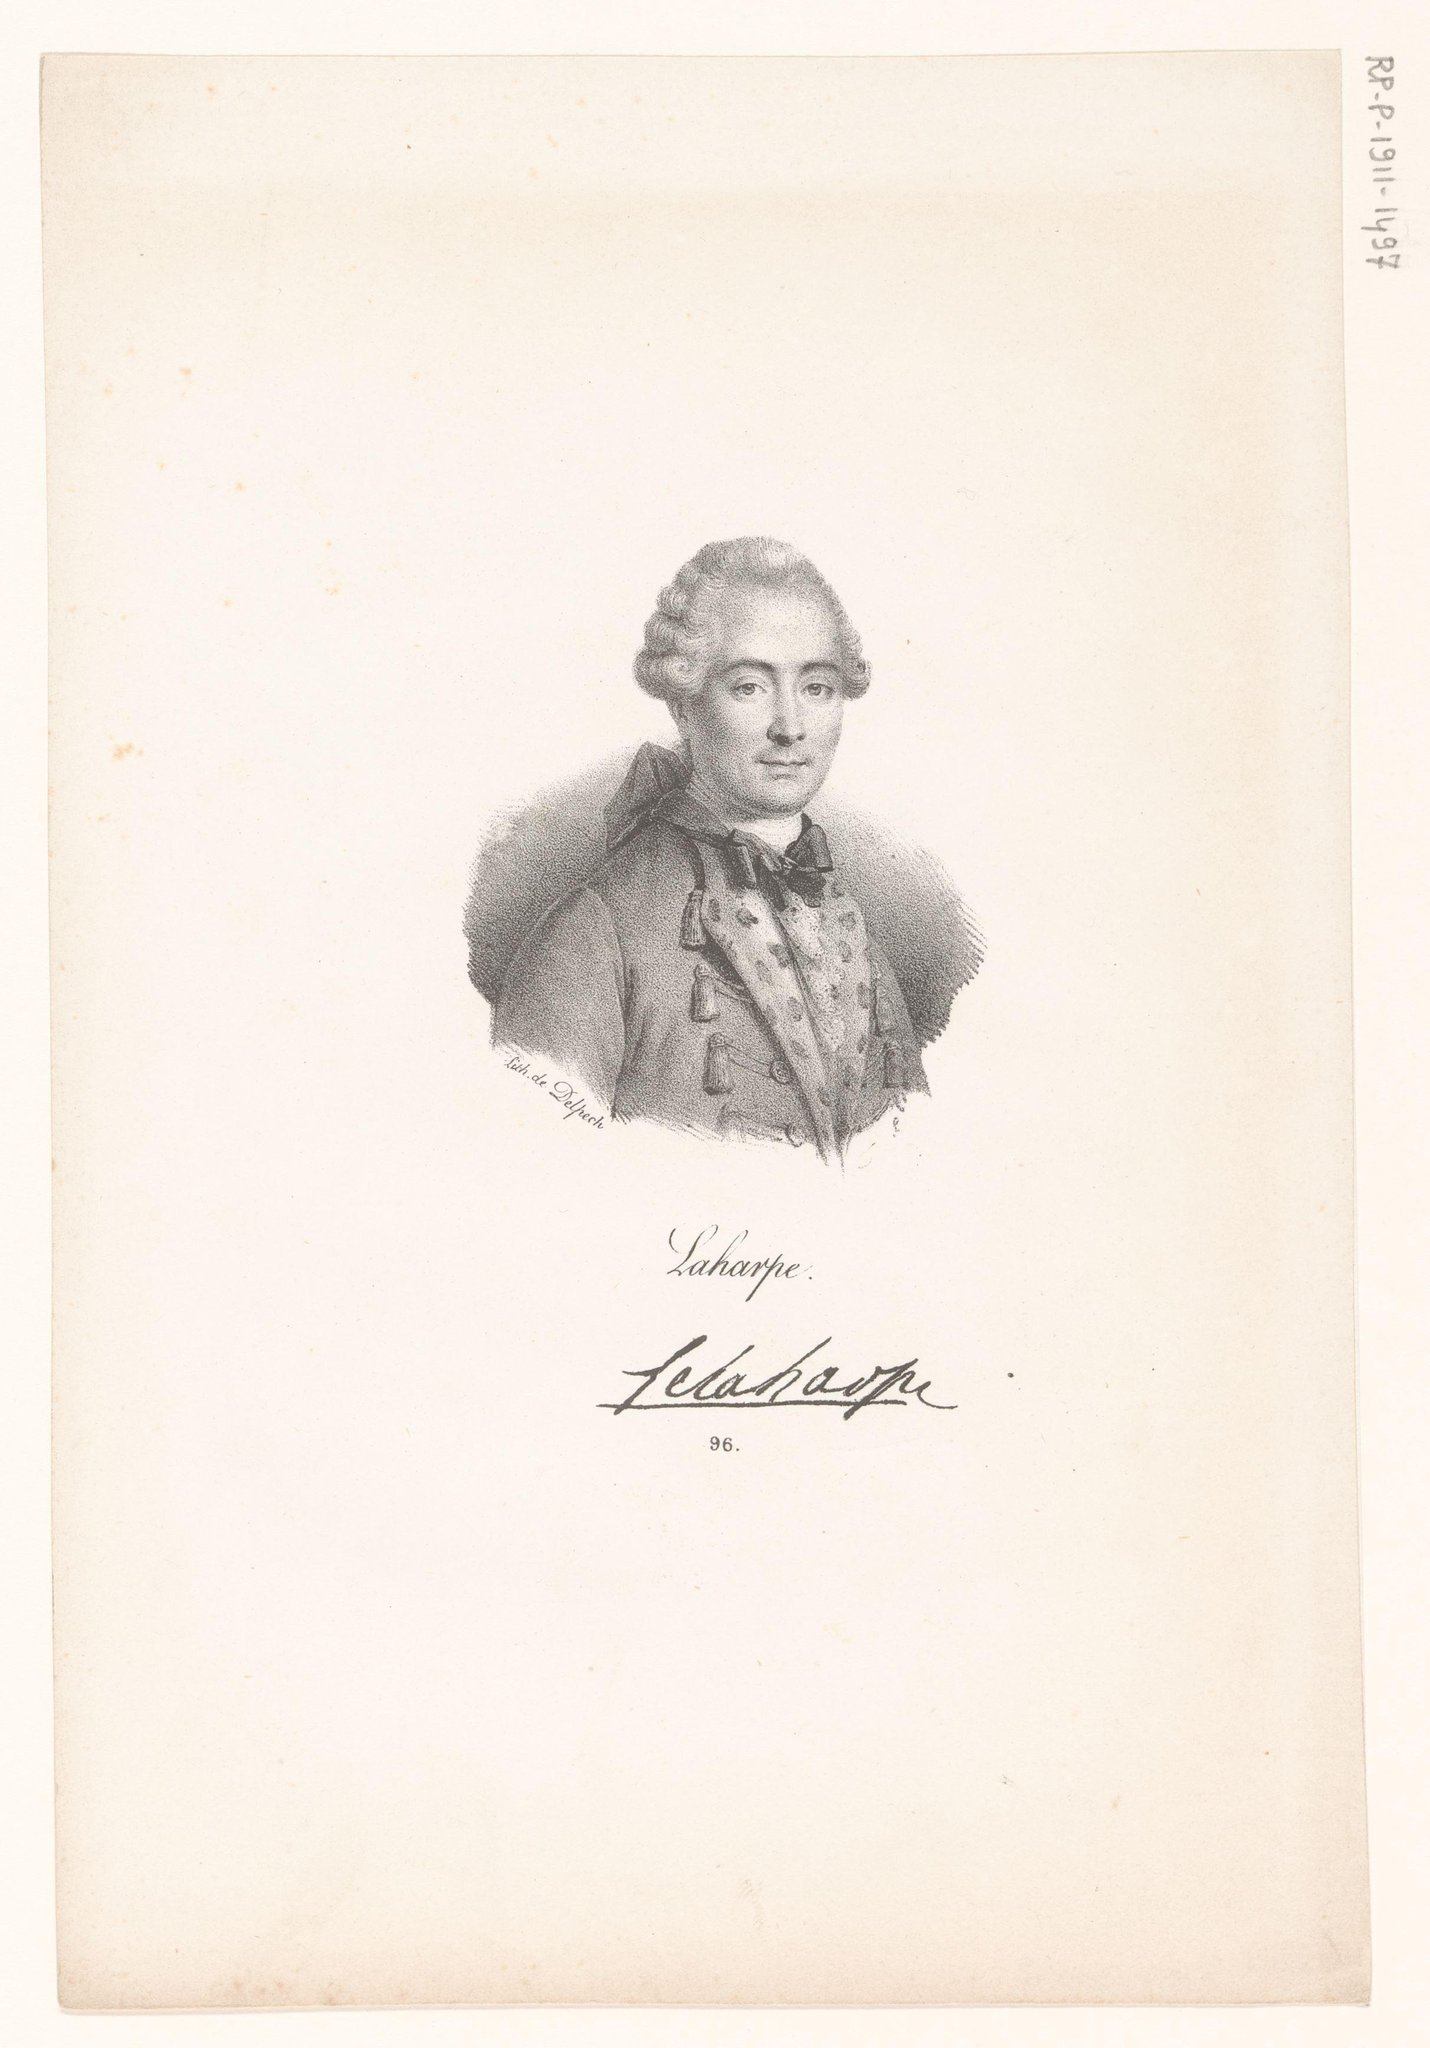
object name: print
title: Portret van Jean-François de La Harpe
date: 1818-1842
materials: paper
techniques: lithograph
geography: paris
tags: paris, historical persons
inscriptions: collector's mark: Lugt 2228a